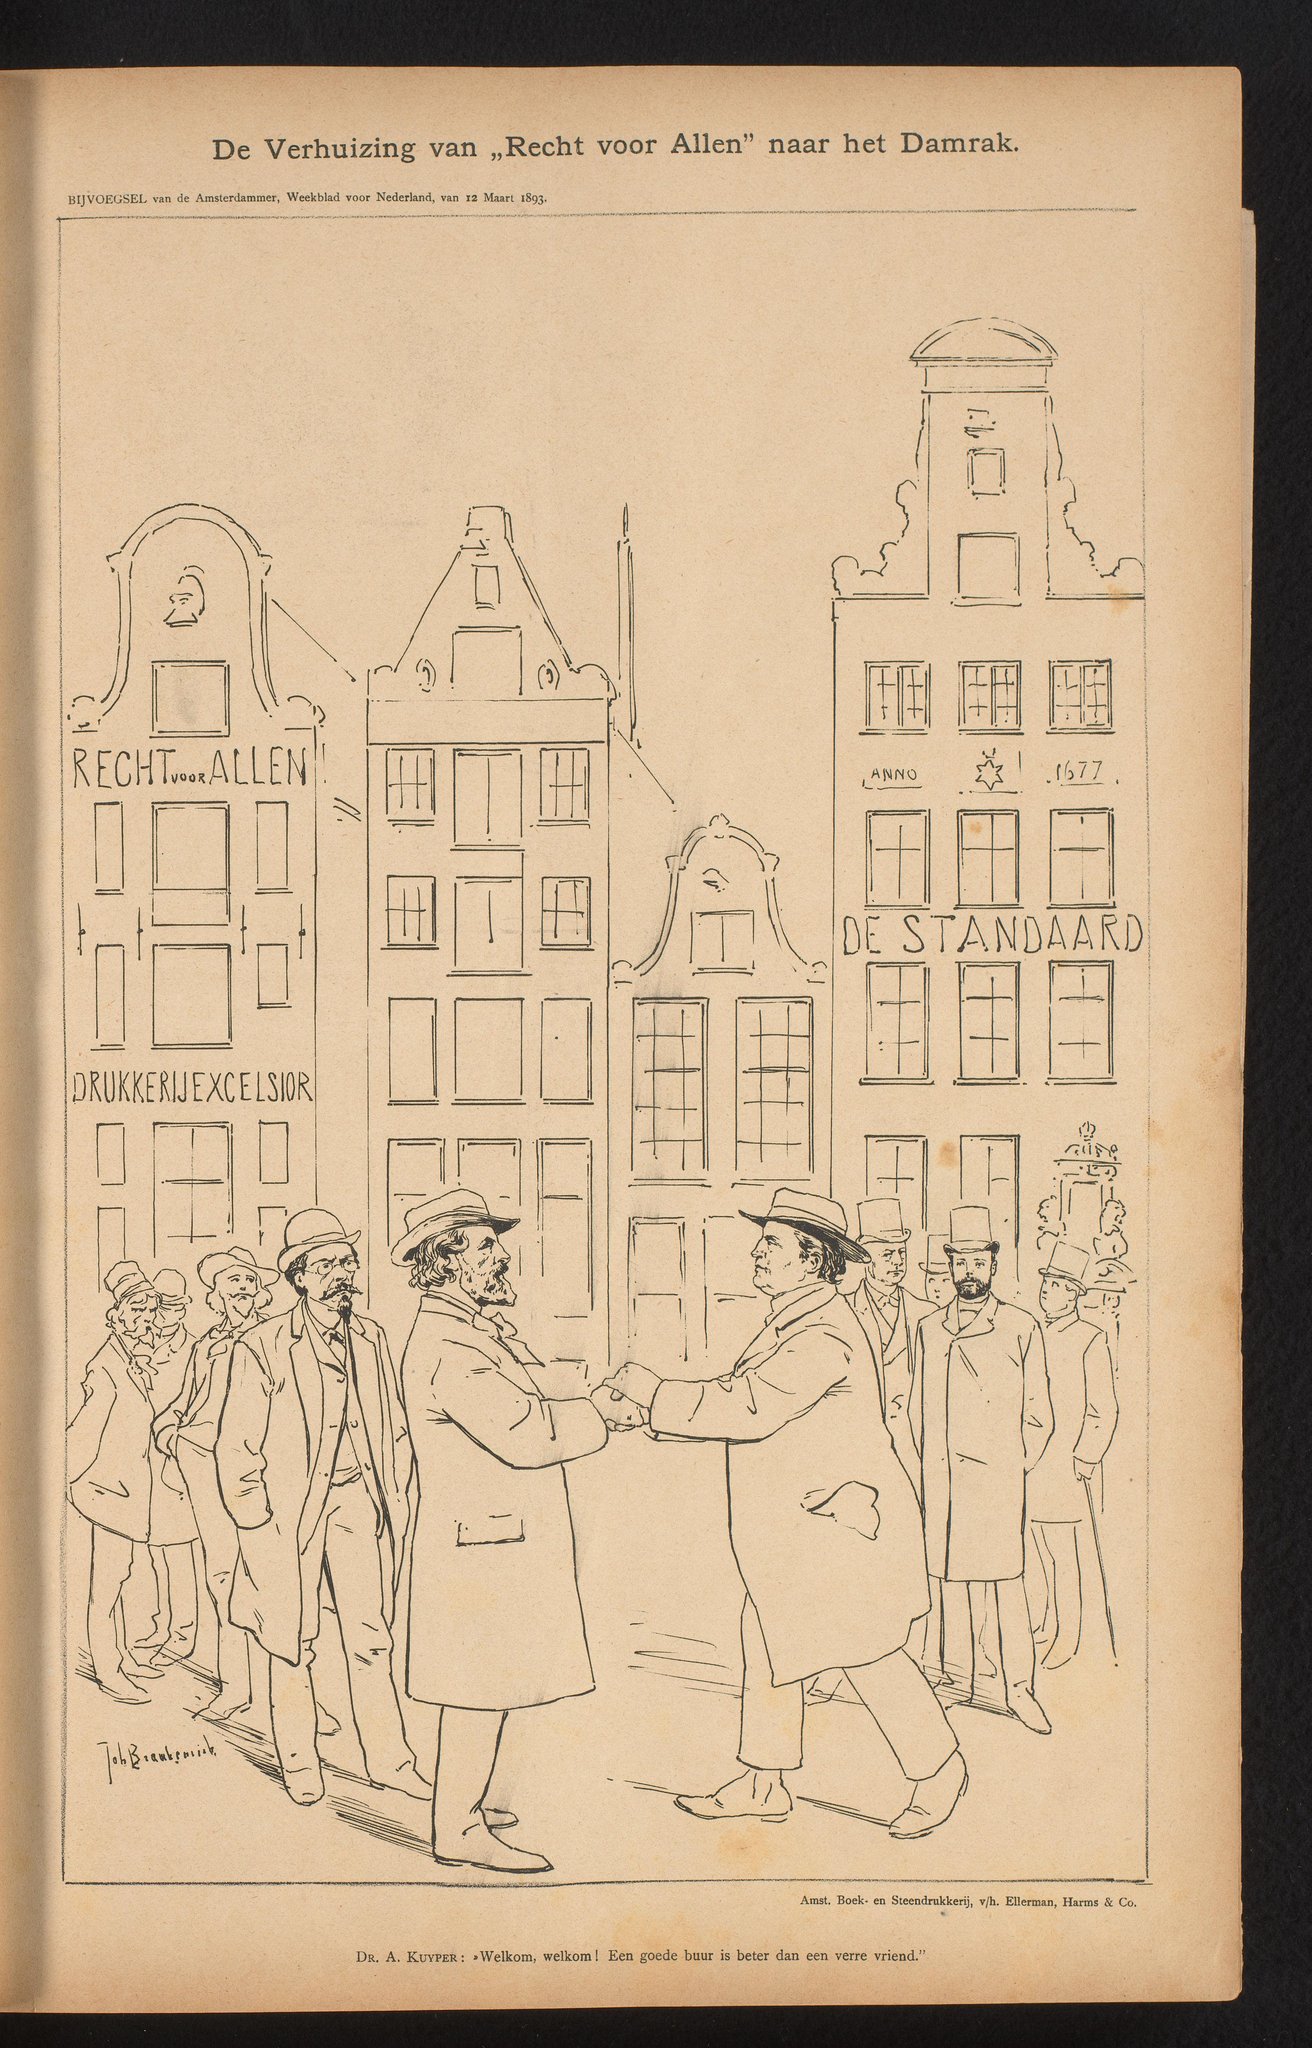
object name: cartoon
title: De Verhuizing van "Recht voor Allen" naar het Damrak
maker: johan braakensiek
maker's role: draughtsman, print maker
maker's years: 1858-1940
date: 1893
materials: paper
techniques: lithograph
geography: netherlands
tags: the hague, abraham kuyper, politician, ferdinand domela nieuwenhuis, newspaper, news-sheet, political caricatures and satires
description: Het sociaaldemocratisch tijdschrift 'Recht voor Allen' onder redactie van Ferdinand Domela Nieuwenhuis verhuist naar een pand aan het Damrak te Amsterdam en wordt daar welkom geheten door Abraham Kuyper van het antirevolutionaire tijdschrift 'De Standaard'.